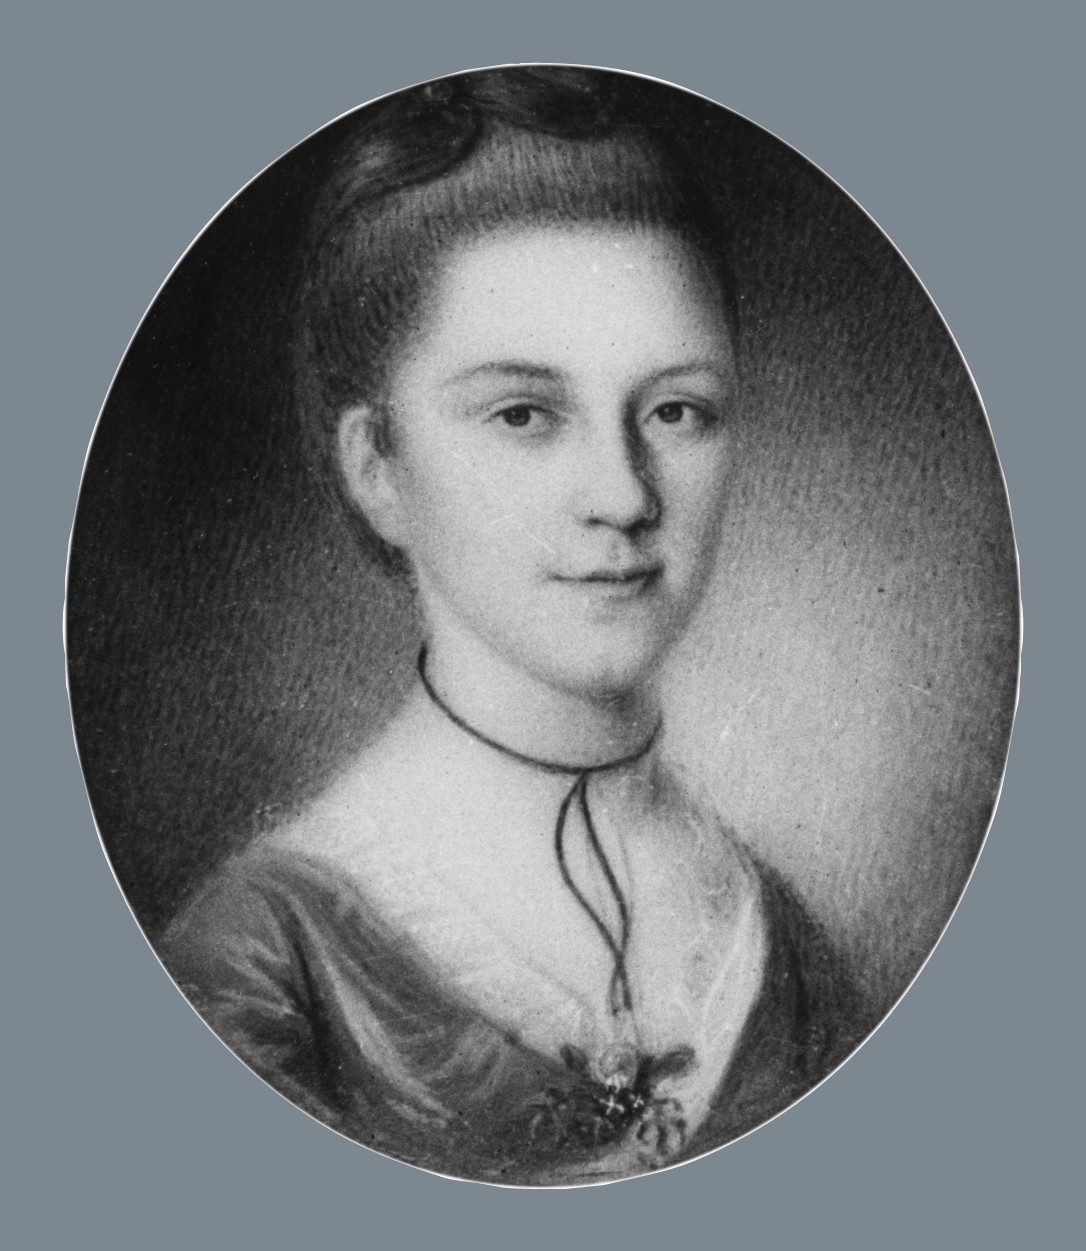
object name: painting, miniature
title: Mrs. Michael Taney (Monica Brooke)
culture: american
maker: charles willson peale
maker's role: artist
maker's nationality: american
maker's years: 1741-1827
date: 1770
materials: ivory, watercolor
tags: portraits,women